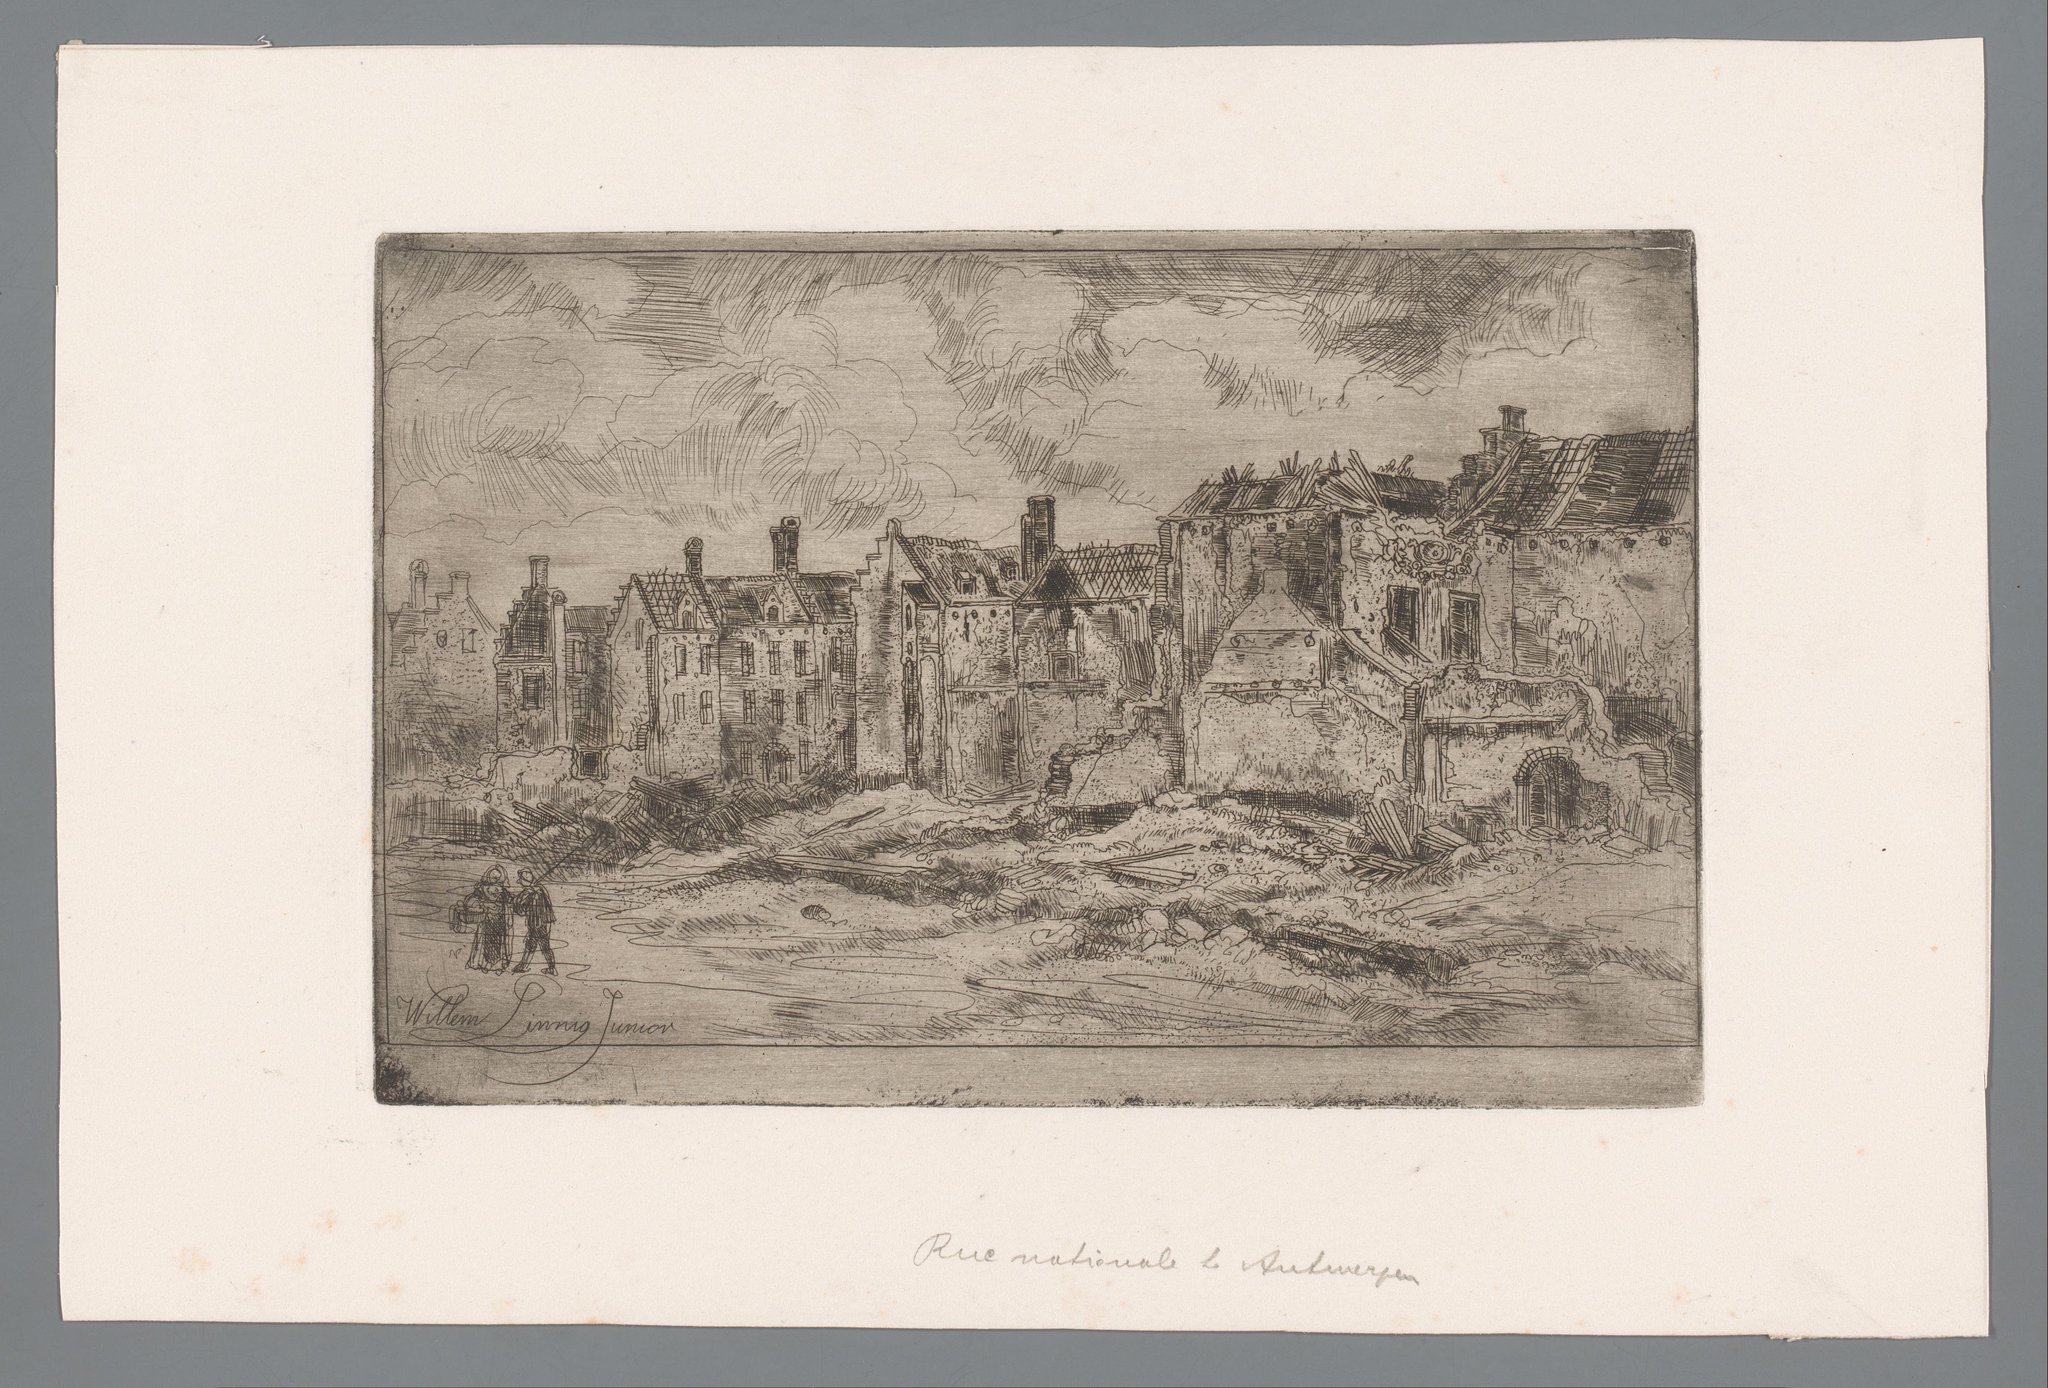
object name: print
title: Ruïnes aan de Rue Nationale te Antwerpen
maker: willem linnig (ii)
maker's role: print maker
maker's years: 1842-1890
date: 1876-1889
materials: paper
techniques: etching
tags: ruin of a building ~ architecture, ruin of a dwelling, house, castle, etc., antwerp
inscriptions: collector's mark: Lugt 2228